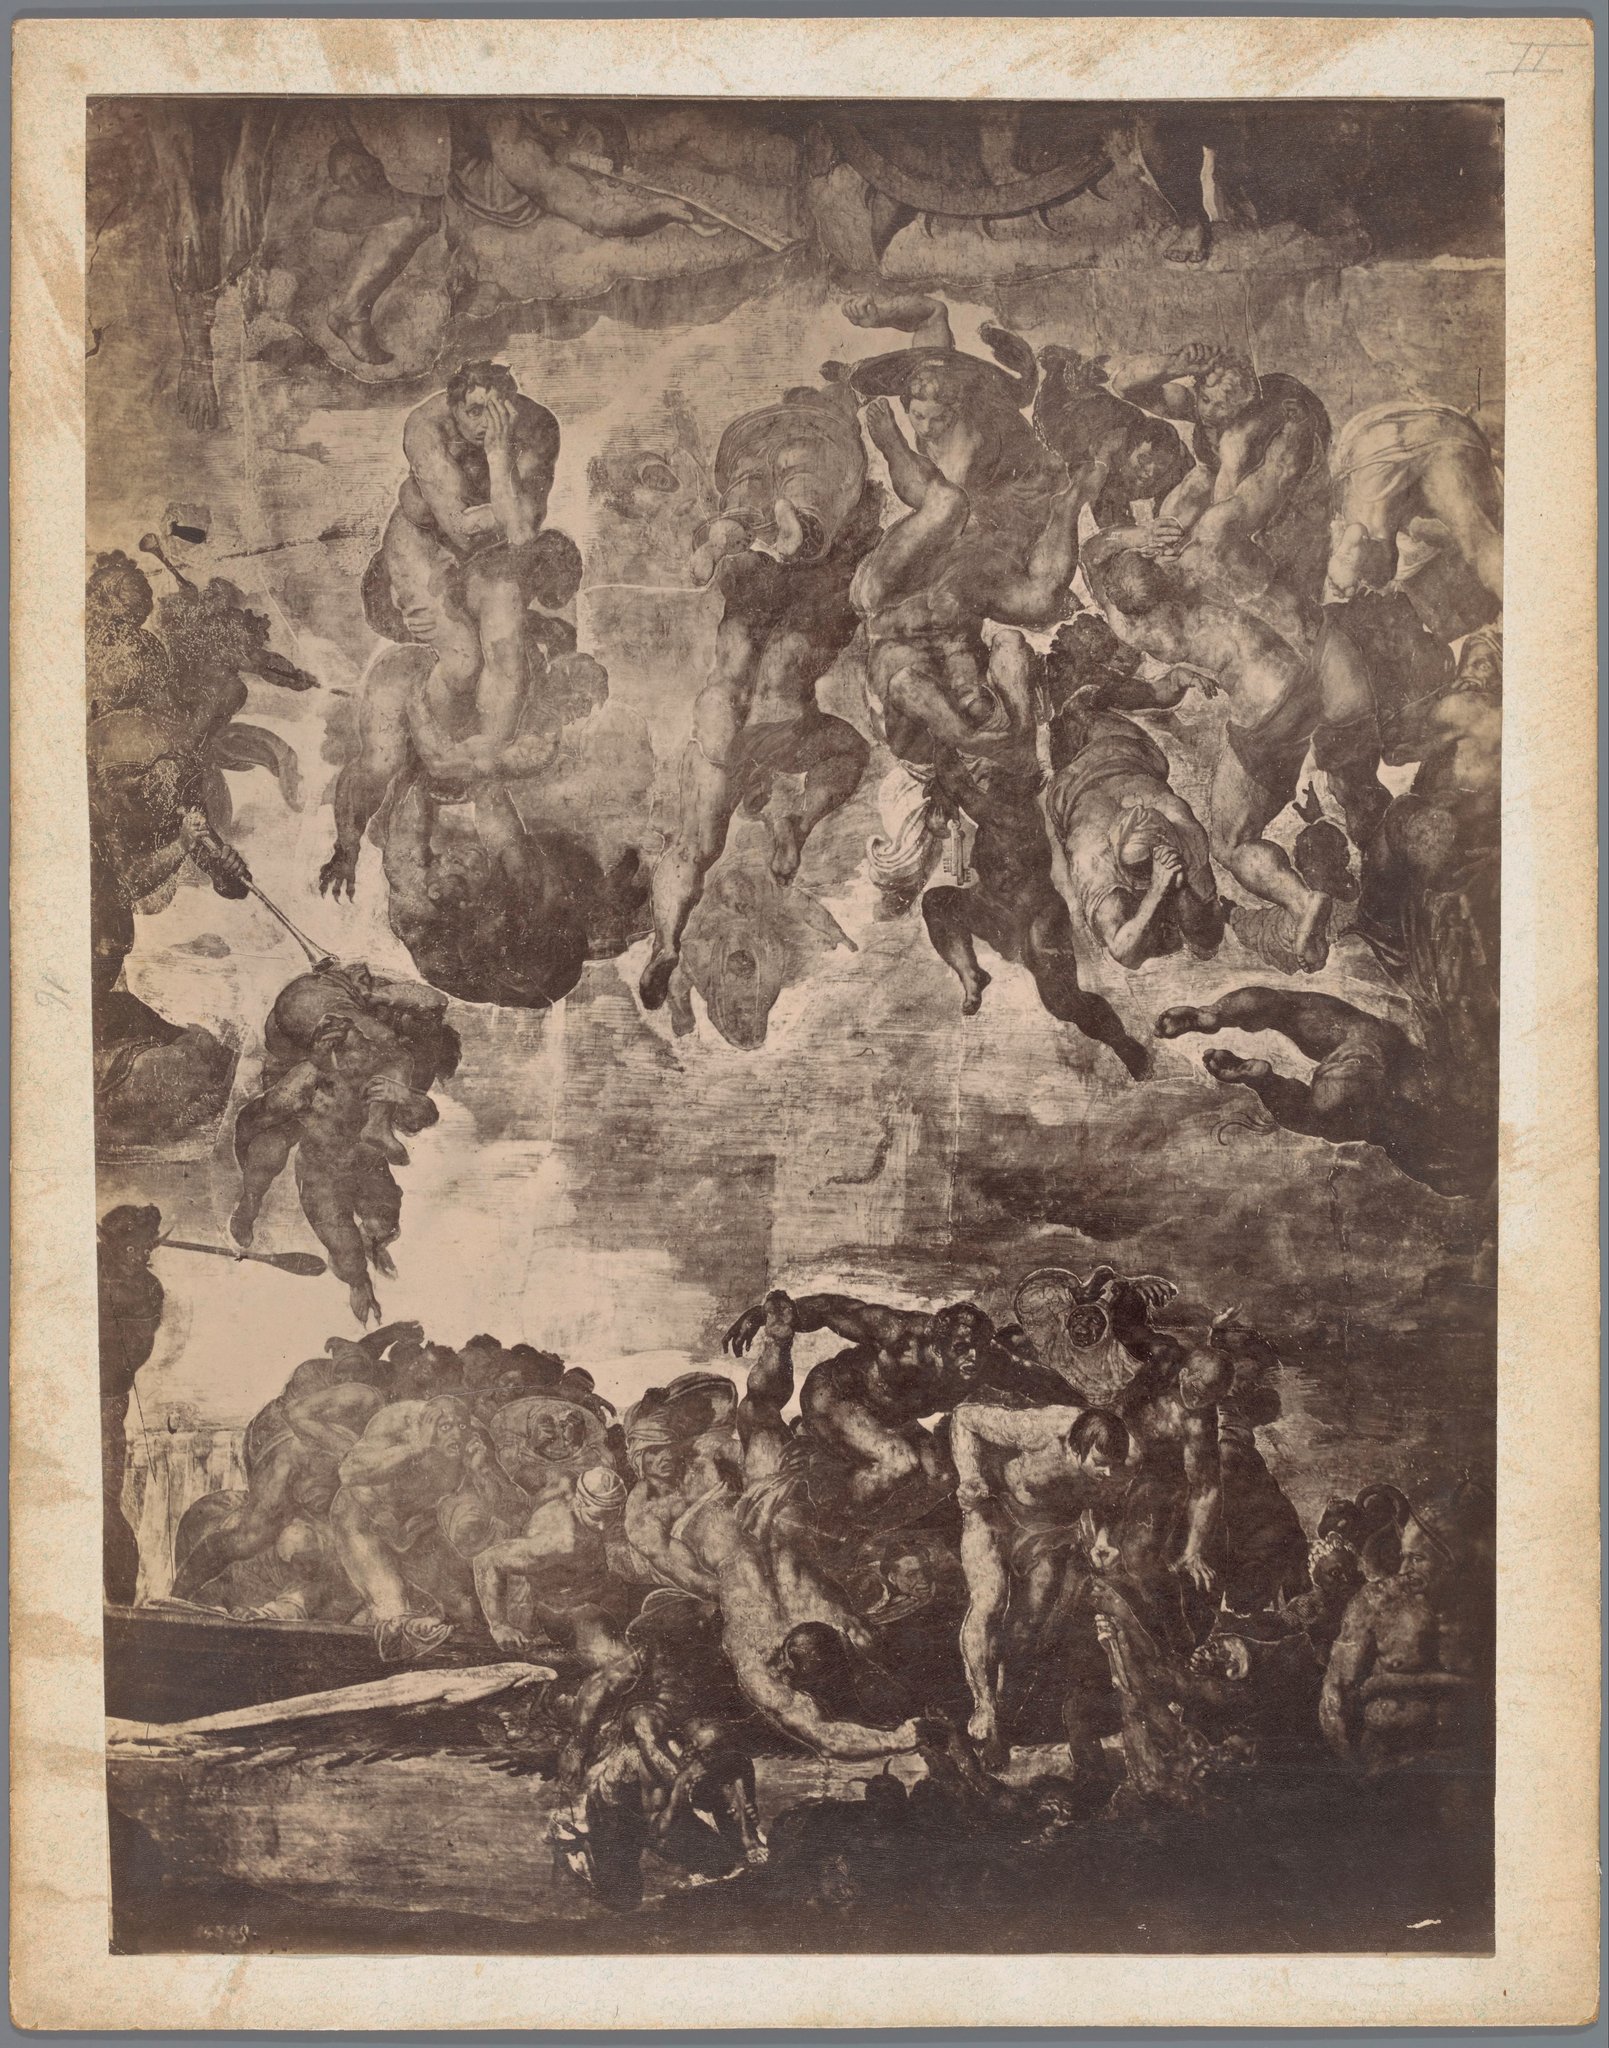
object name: photograph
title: Fotoreproductie van een deel van de fresco's op de muur van de Sixtijnse Kapel door Michelangelo te Vaticaanstad , voorstellende het Laatste Oordeel en het werpen van de verdoemden in de hel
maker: Anonymous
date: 1875-1900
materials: cardboard, photographic support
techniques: albumen print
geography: vatican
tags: last judgement, devil(s) and demons, the fall of the damned ~ last judgement, charon, the ferryman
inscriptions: collector's mark: Lugt 3937, number: ‘14549.’